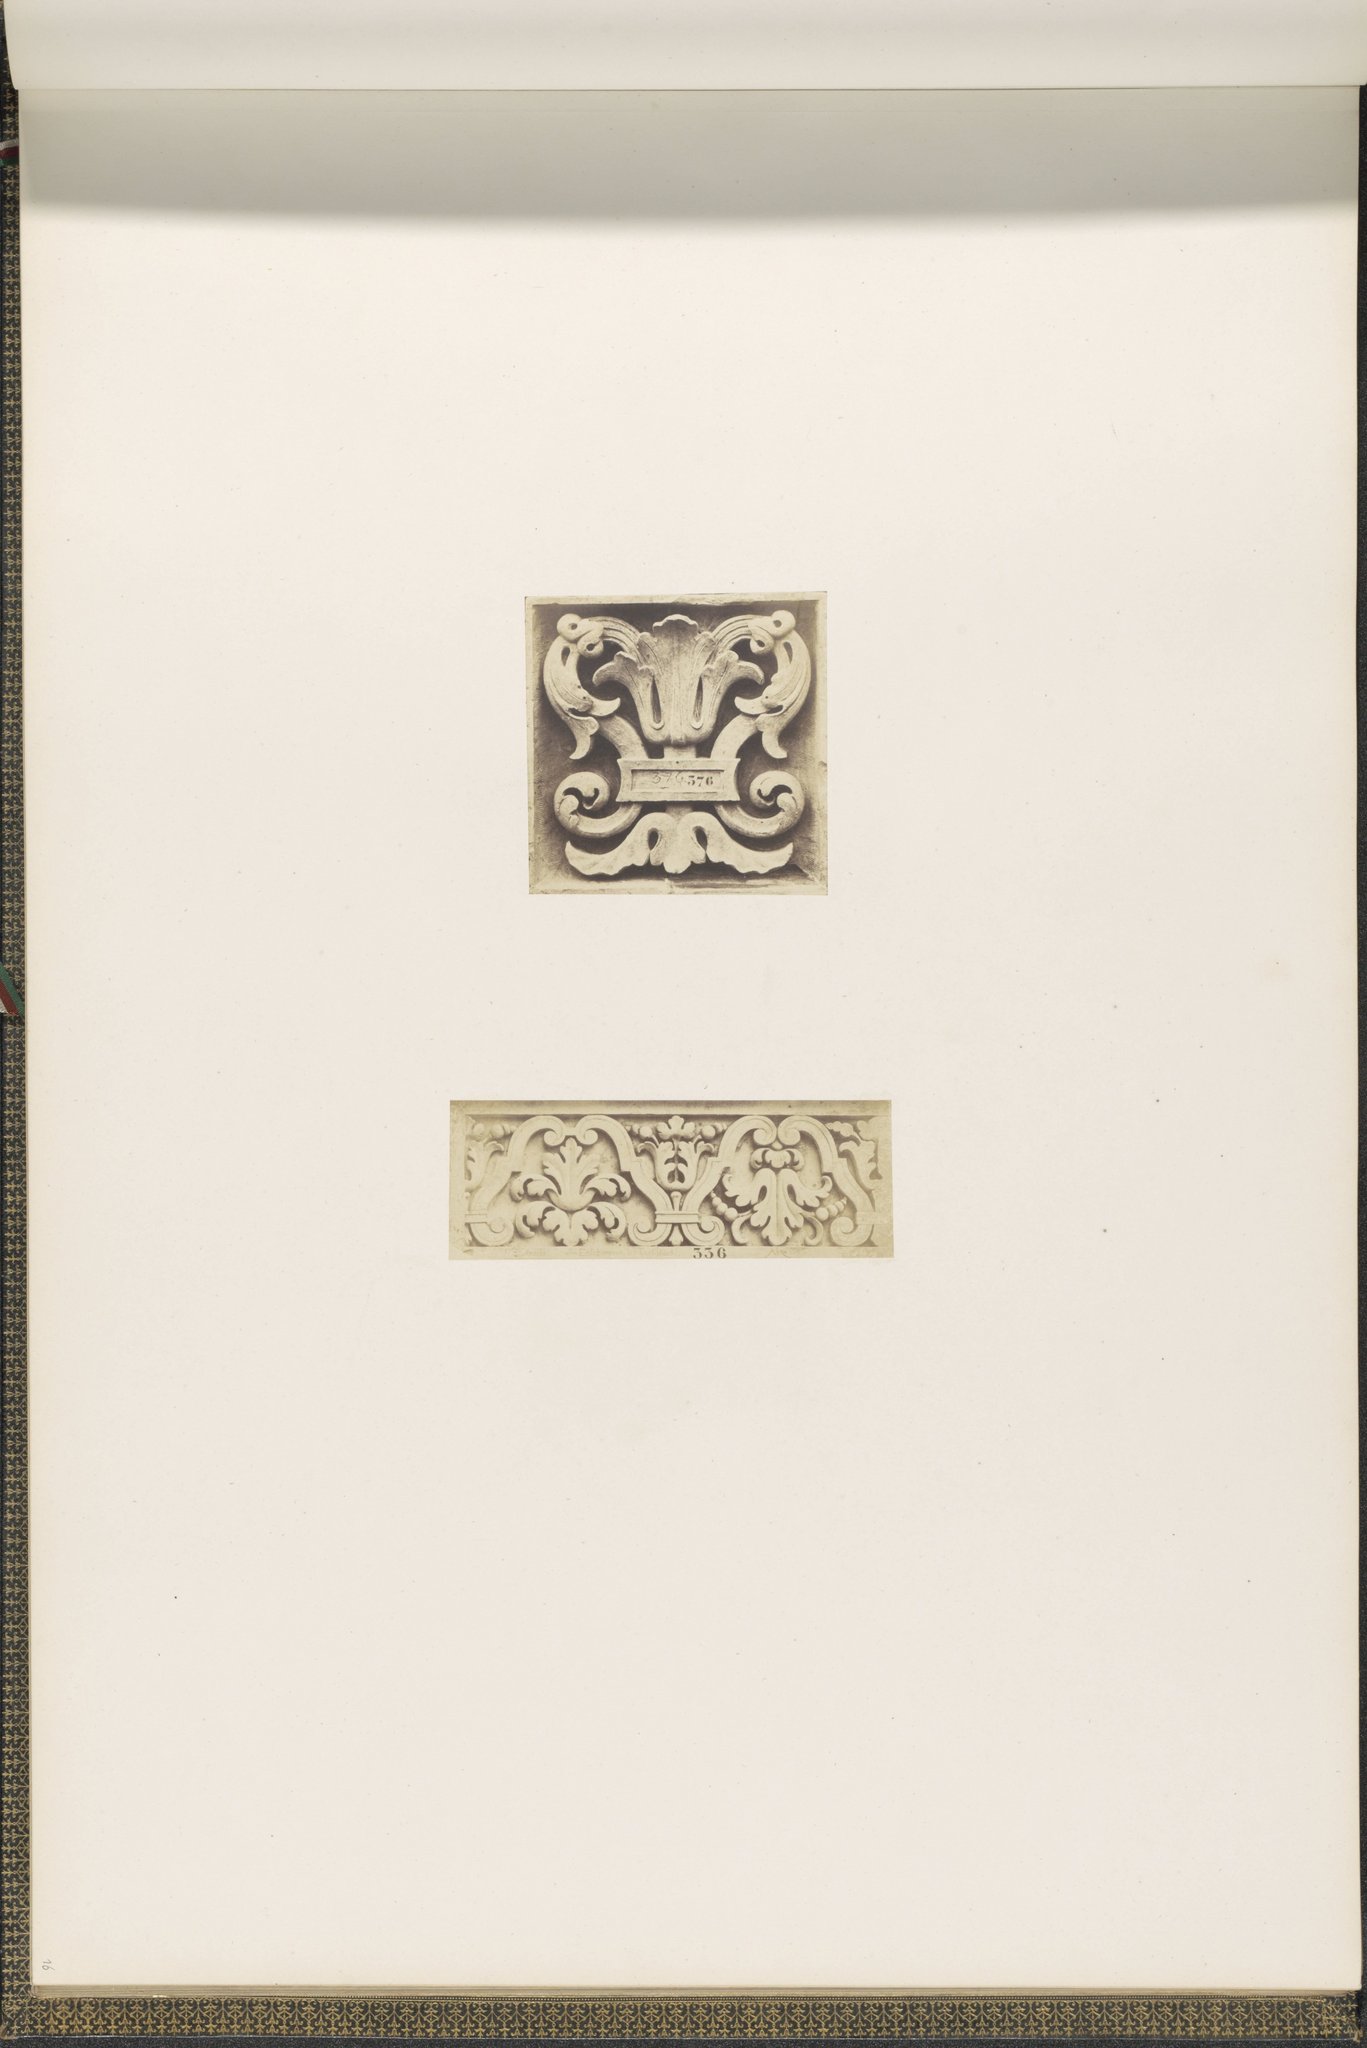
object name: album leaf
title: Gipsmodellen voor versieringen op de Bibliothèque Impériale van het Palais du Louvre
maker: édouard denis baldus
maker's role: fotograaf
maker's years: 1813-1889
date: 1855-1857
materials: paper, photographic support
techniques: salted paper print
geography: paris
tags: permanent exhibition, museum, ornamenting, decorating ~ applied arts, paris, tuileries palace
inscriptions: number: ‘376 en 336’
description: Onderdeel van Réunion des Tuileries au Louvre 1852-1857, album 4.